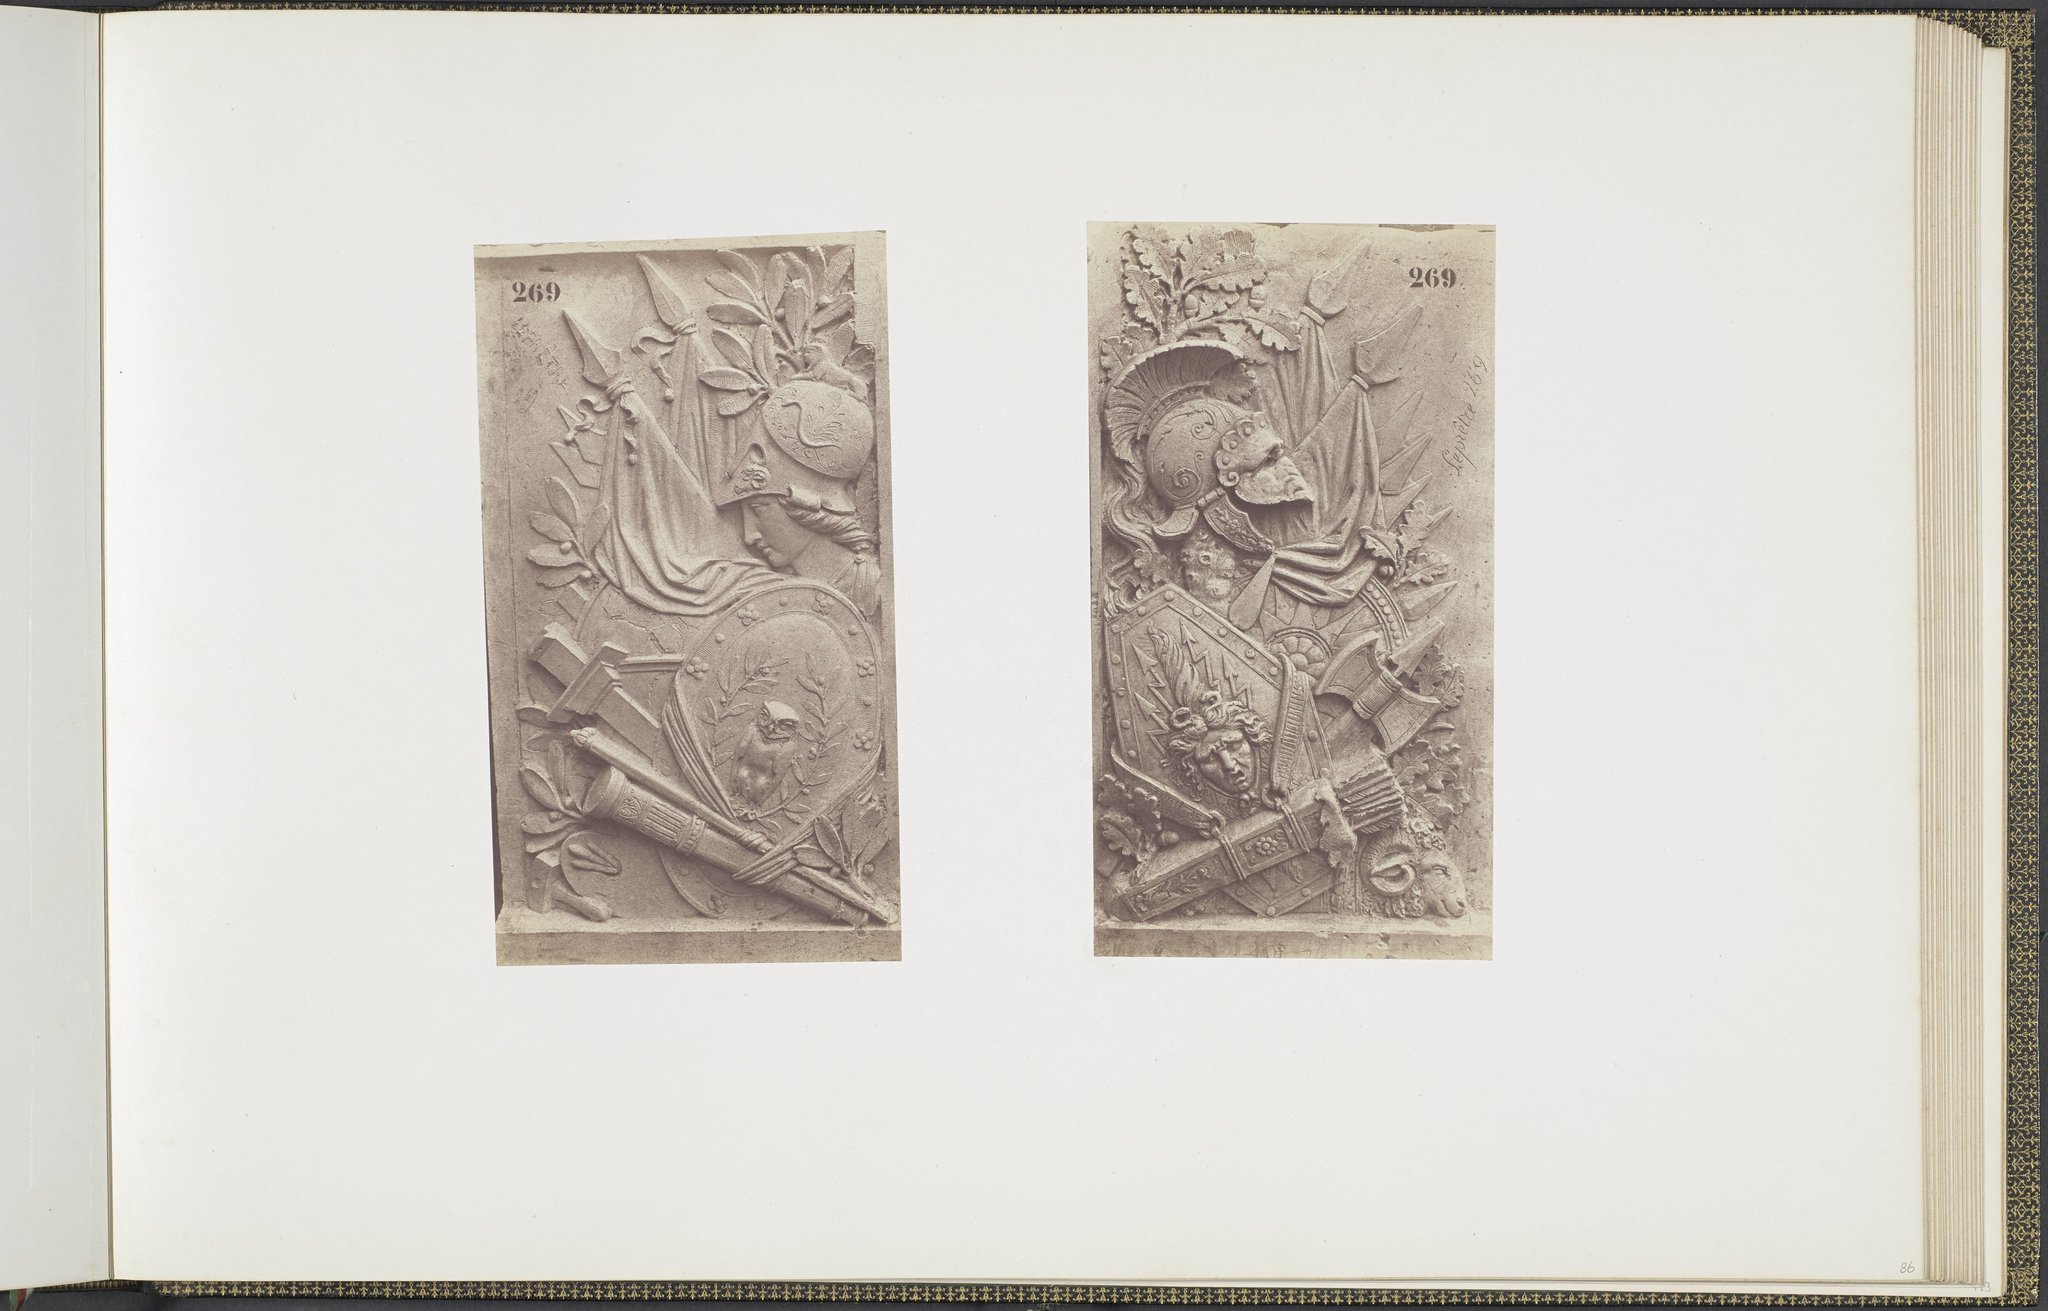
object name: album leaf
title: Gipsmodellen voor beeldhouwwerken op het Palais du Louvre: links "La Victoire" door Antoine-Louis Barye en rechts vervaardiger onbekend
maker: édouard denis baldus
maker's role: fotograaf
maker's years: 1813-1889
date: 1855-1857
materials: paper, photographic support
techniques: salted paper print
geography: paris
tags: piece of sculpture, reproduction of a piece of sculpture, permanent exhibition, museum, paris, tuileries palace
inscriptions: number: ‘269’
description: Onderdeel van Réunion des Tuileries au Louvre 1852-1857, album 1.